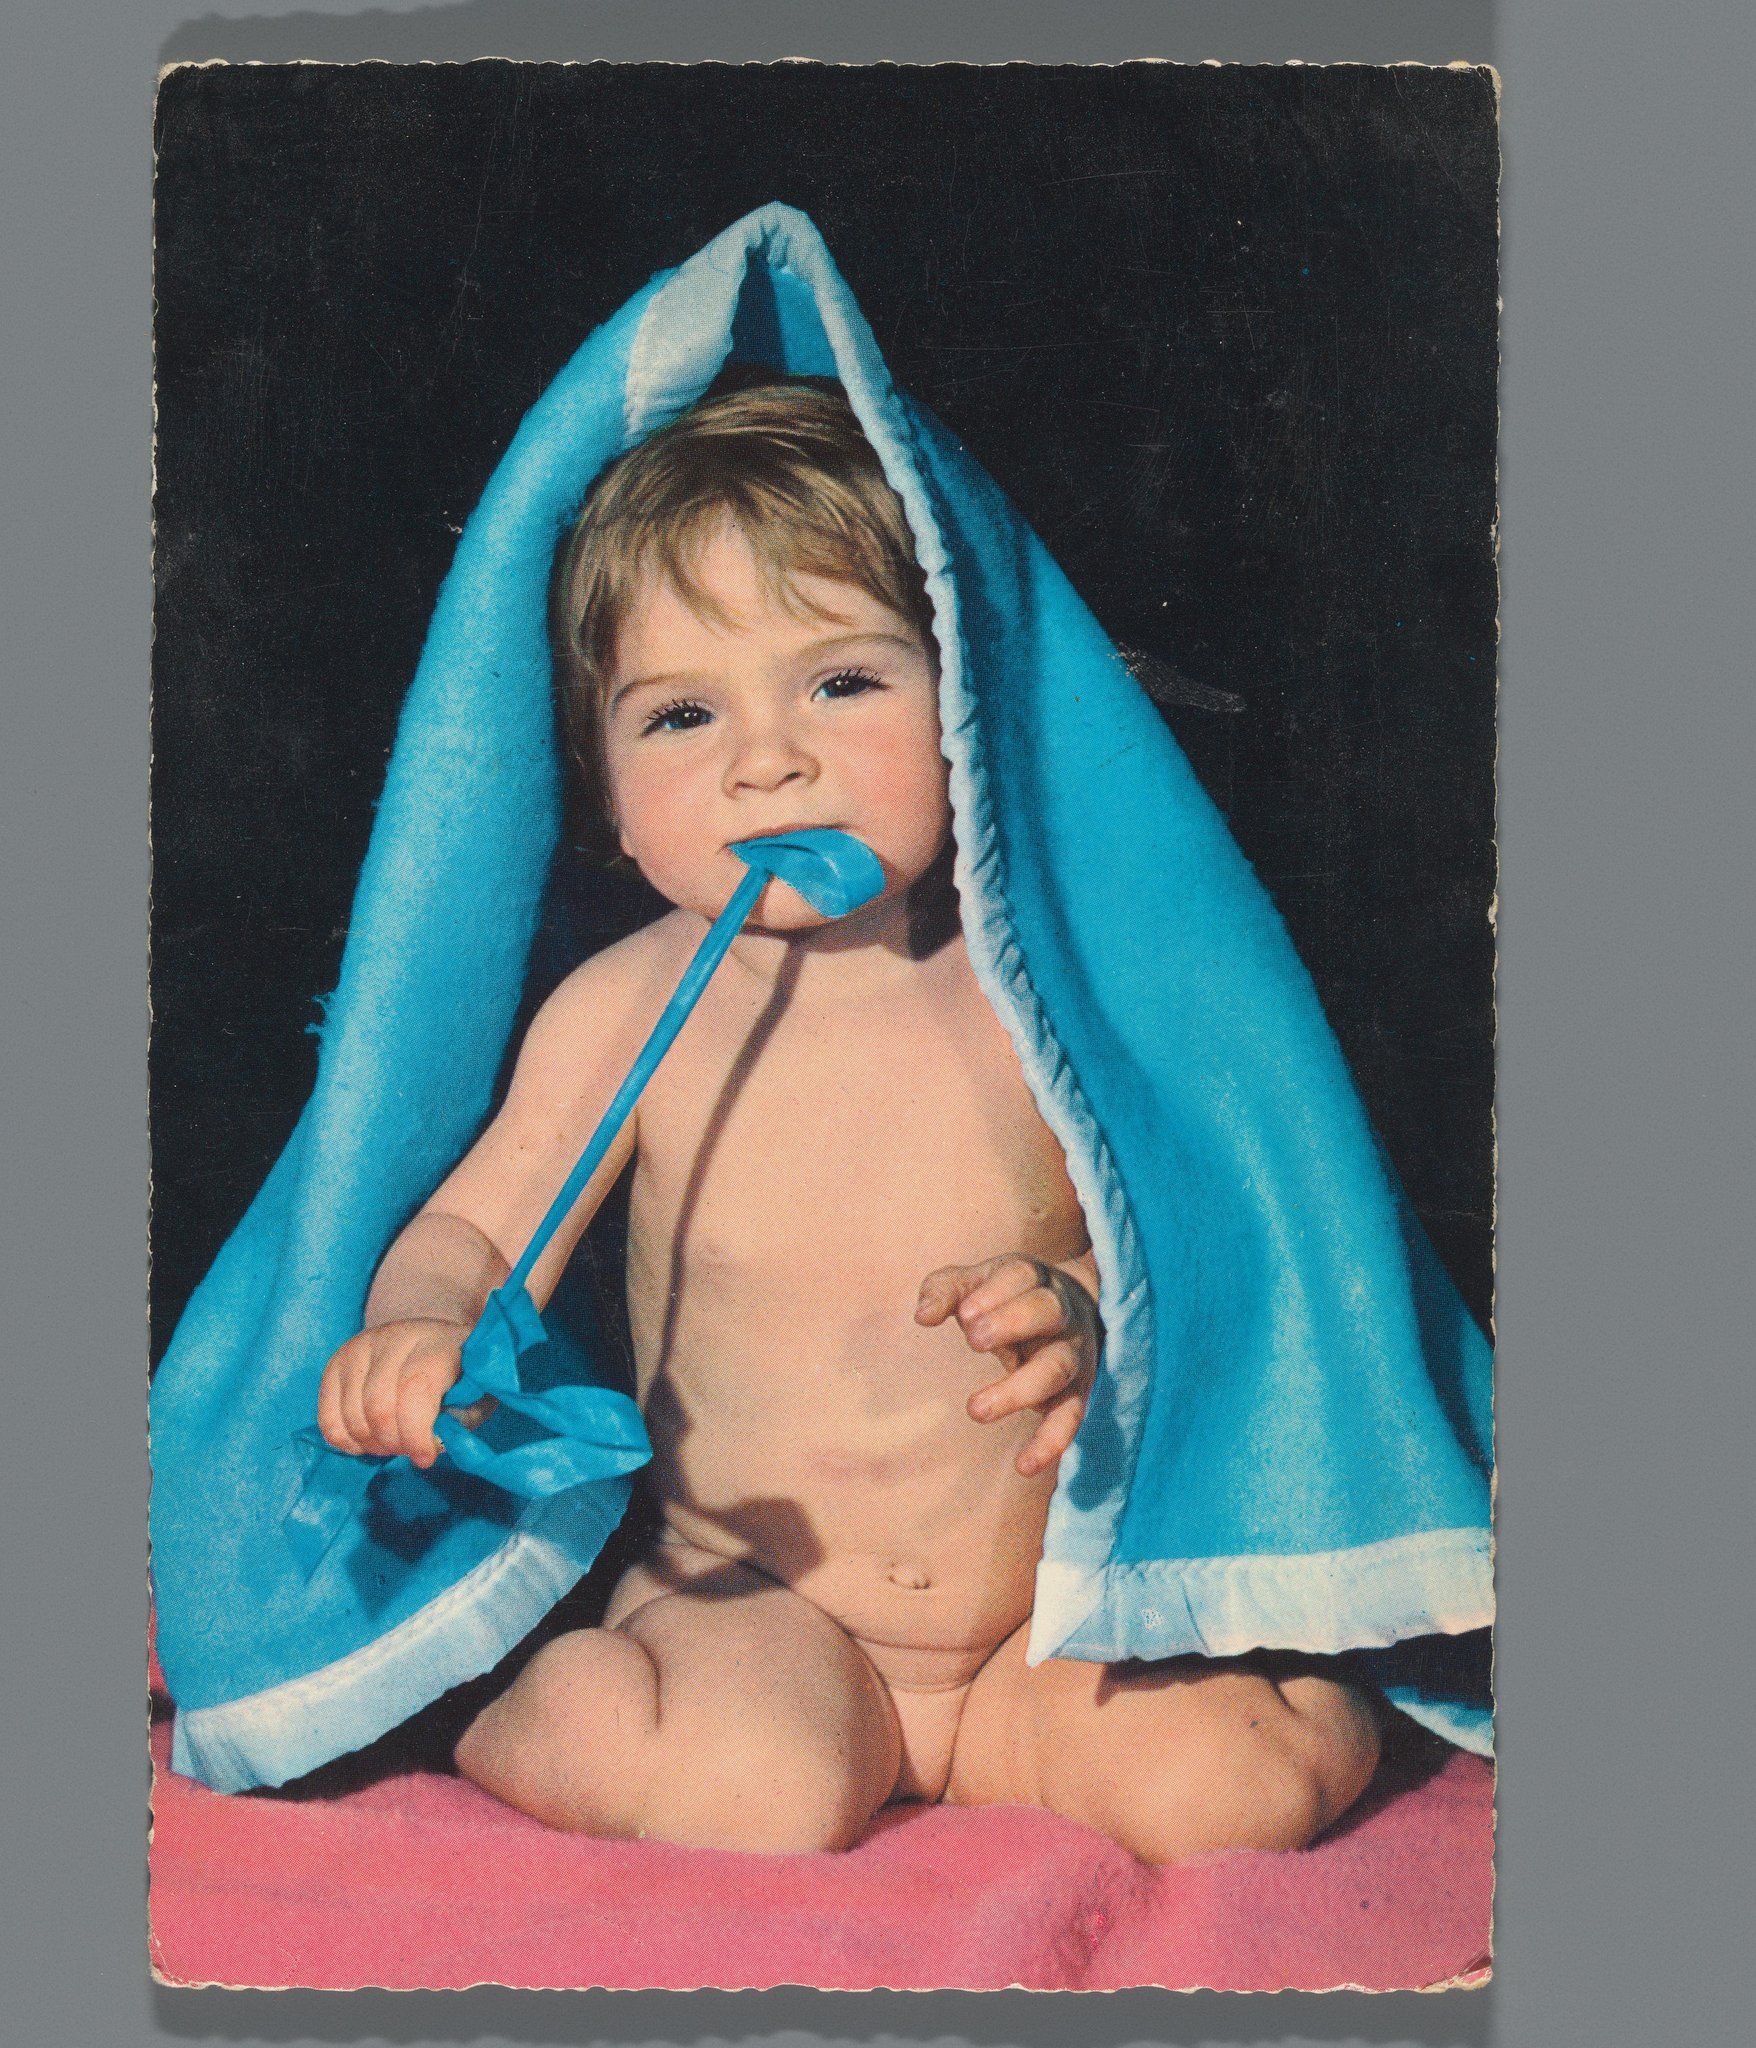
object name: photomechanical print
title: Portret van een onbekend naakt meisje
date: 1968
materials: ink, paper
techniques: writing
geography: hamburg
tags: toddler - aa - girl, anonymous historical person portrayed - bb - woman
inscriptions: inscription: ‘vele kusjes van/ Papa en Mama/ Nancy Broekhuizen/ Coen Cuserhuis/ Olie Slagerslaan 5/ Haarlem’